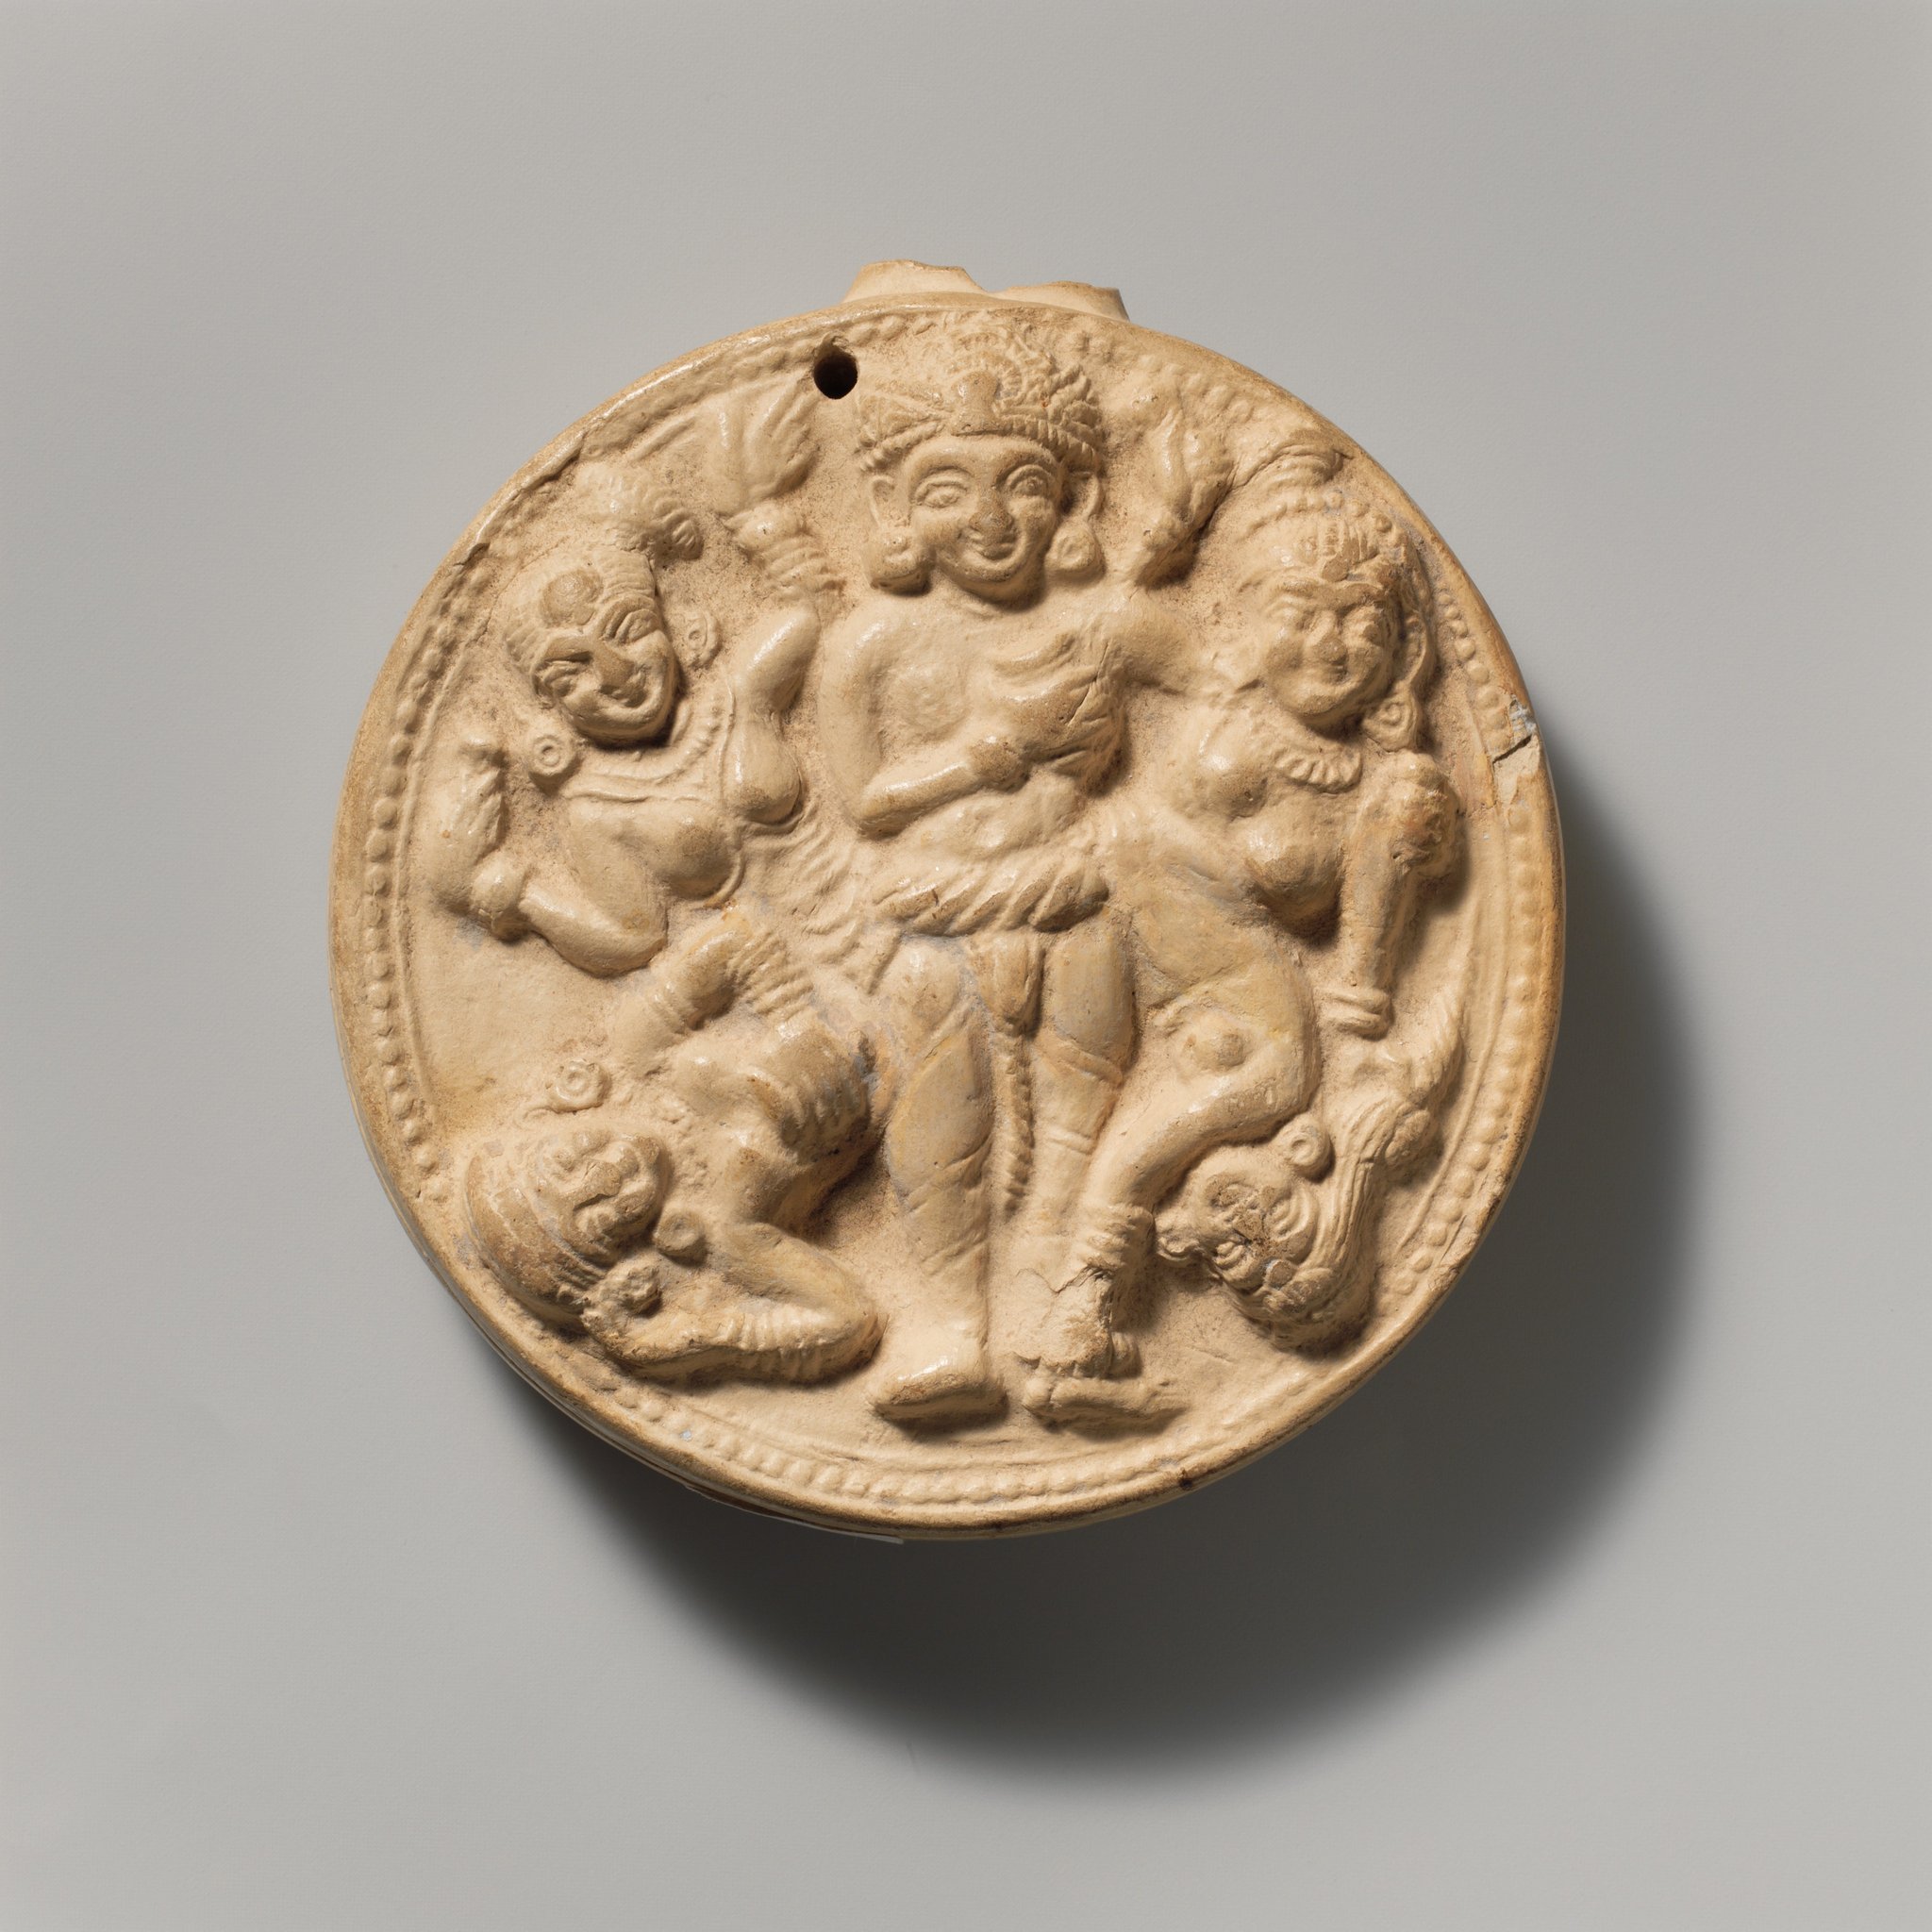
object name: ceramic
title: Auspicious Emblem with Five Revelers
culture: indian, uttar pradesh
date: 1-200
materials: terracotta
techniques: molding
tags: female nudes,emblems